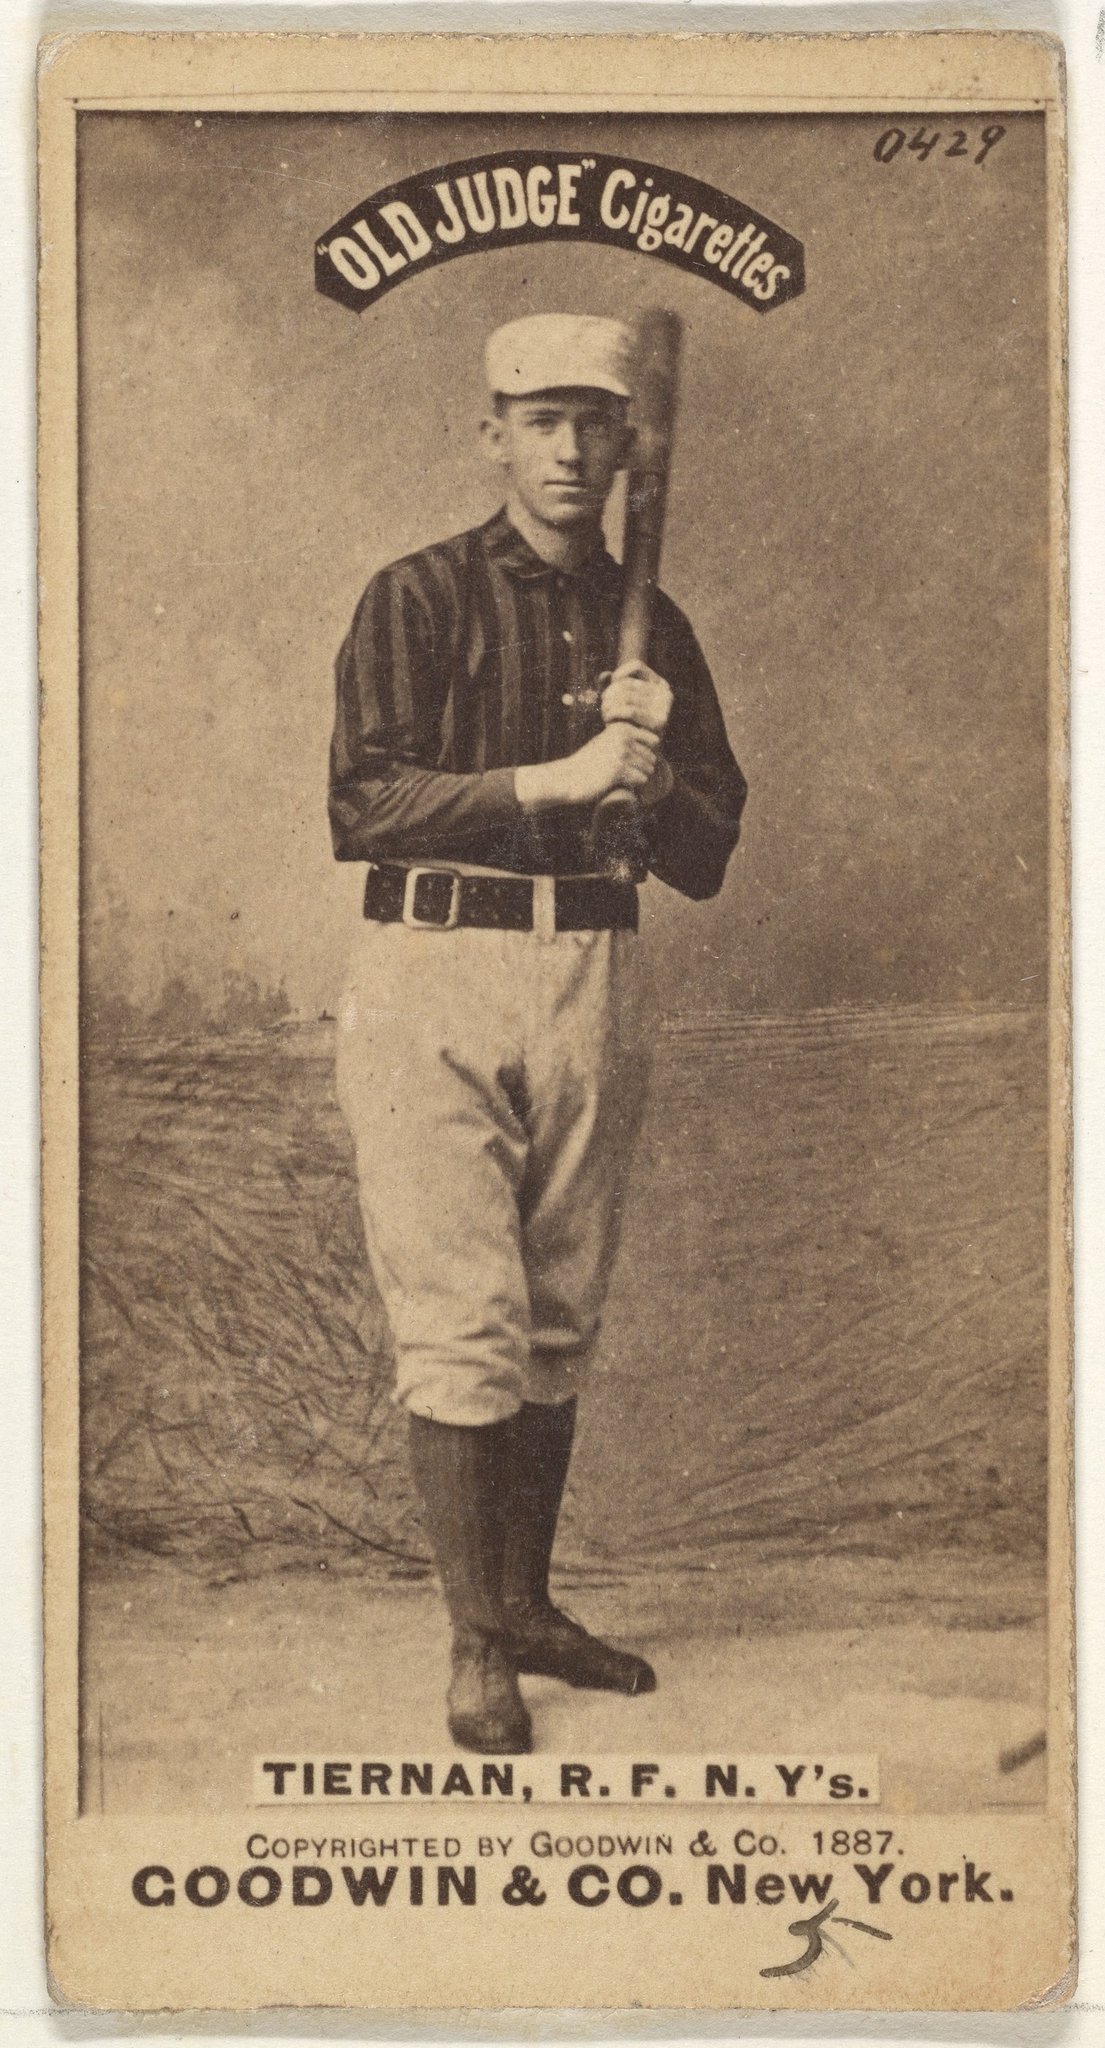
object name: baseball card, photograph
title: Michael "Silent Mike" Joseph Tiernan, Right Field, New York, from the Old Judge series (N172) for Old Judge Cigarettes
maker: goodwin & company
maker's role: publisher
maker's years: 1850-1950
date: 1887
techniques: albumen silver print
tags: men,portraits,baseball,athletes